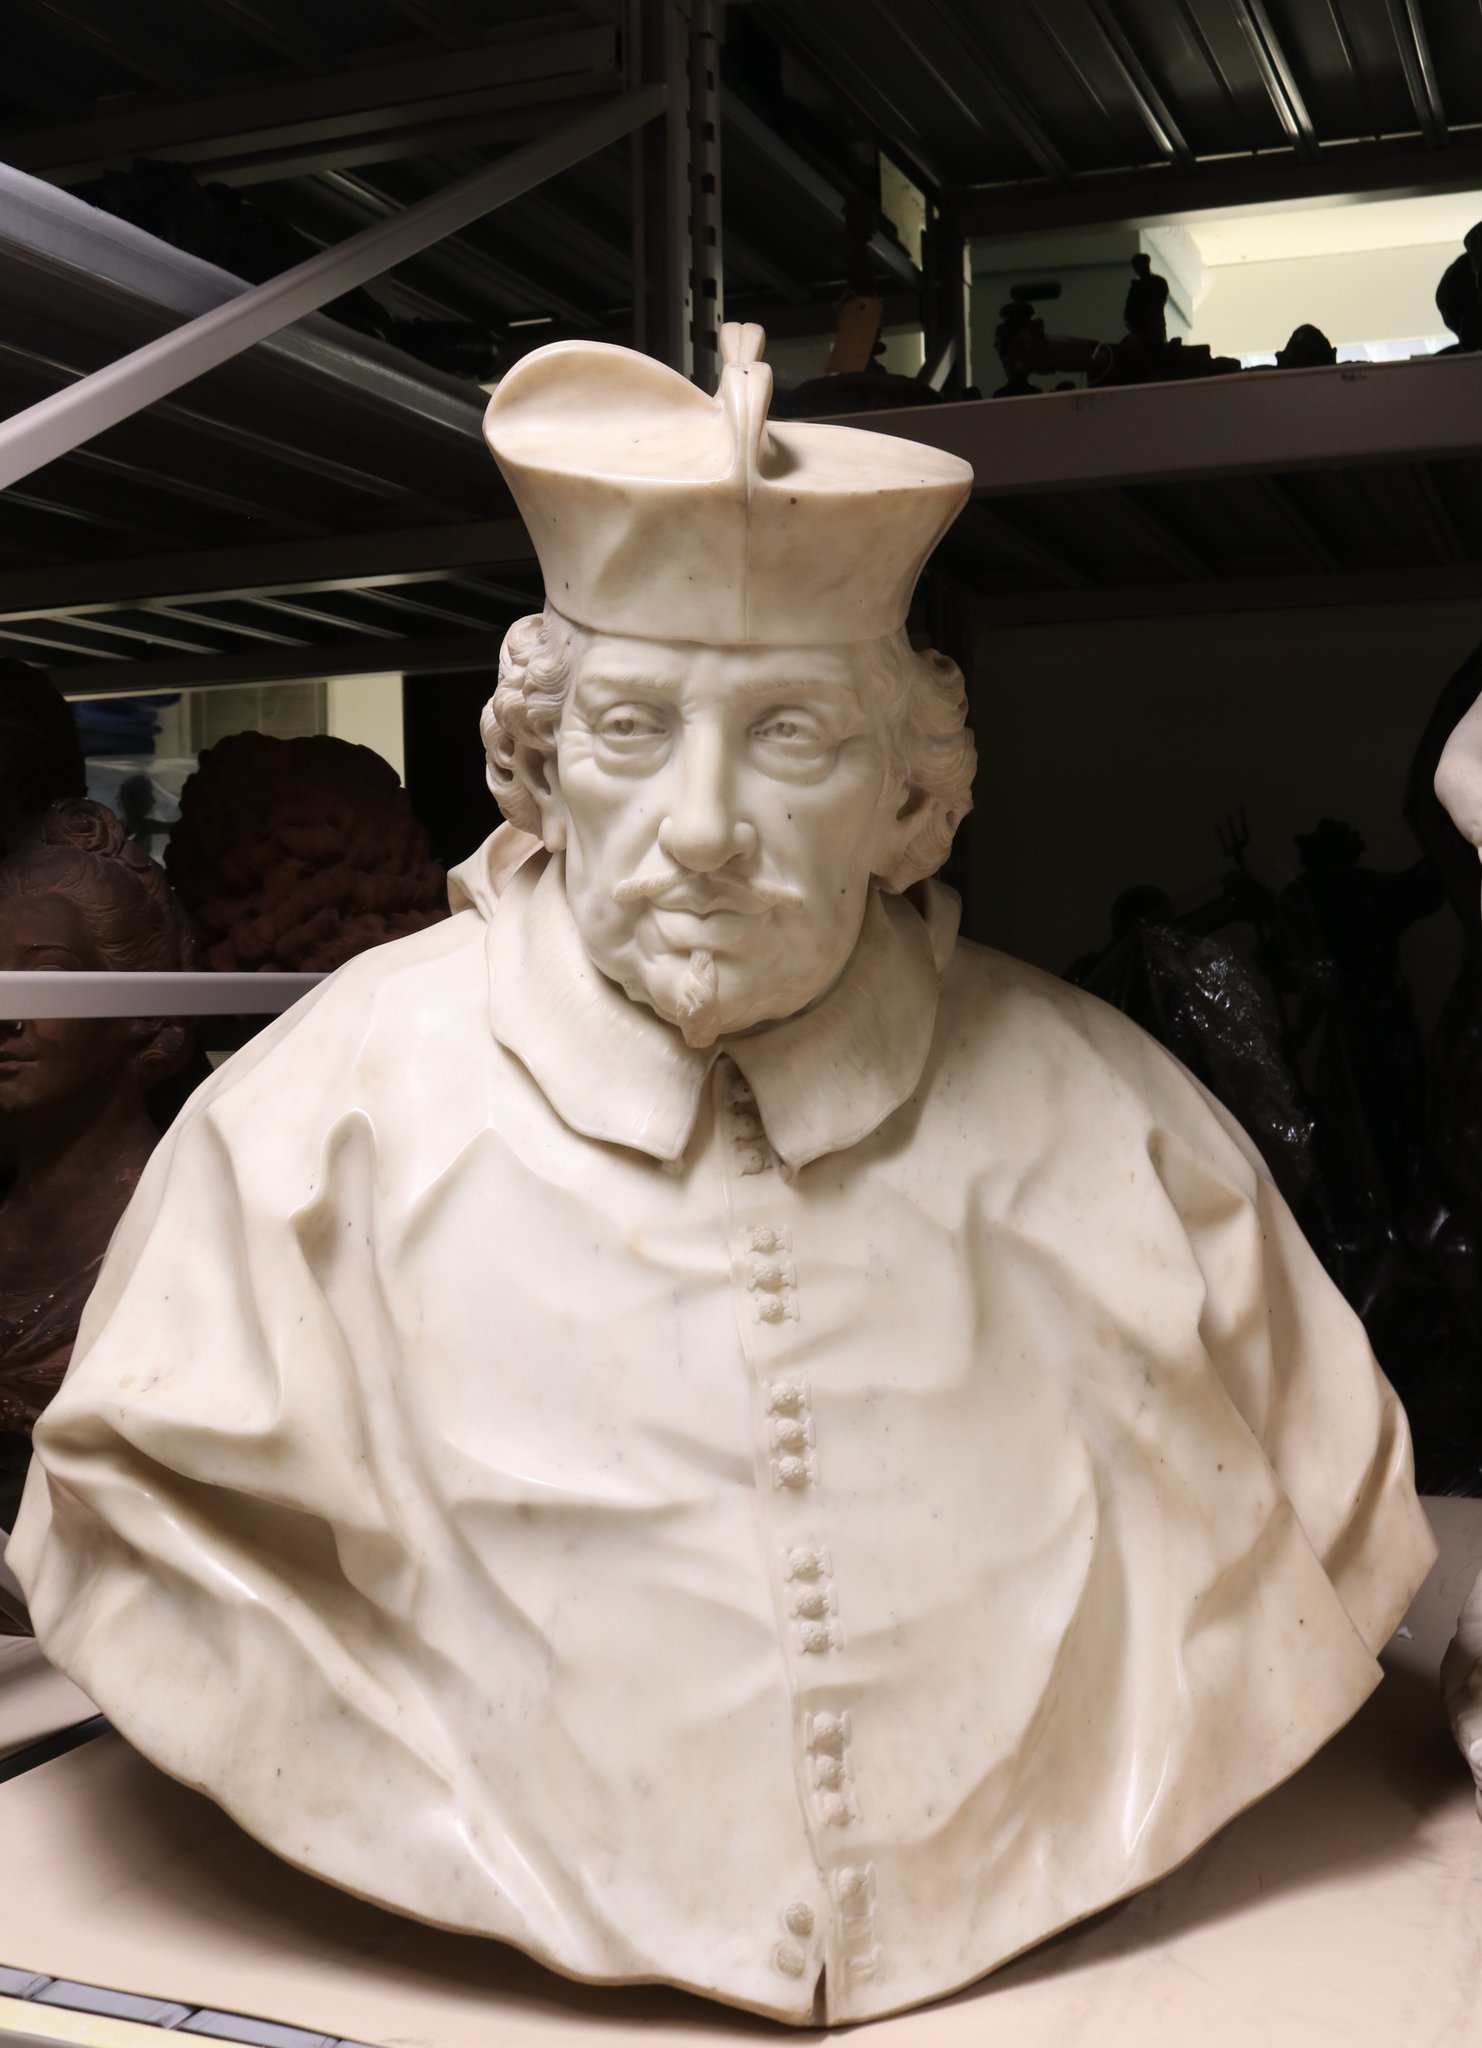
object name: bust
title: Cardinal Raimondo Capizucchi (1616–1691)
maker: domenico guidi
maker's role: artist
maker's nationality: italian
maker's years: 1625-1701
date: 1681-1691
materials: marble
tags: men,portraits